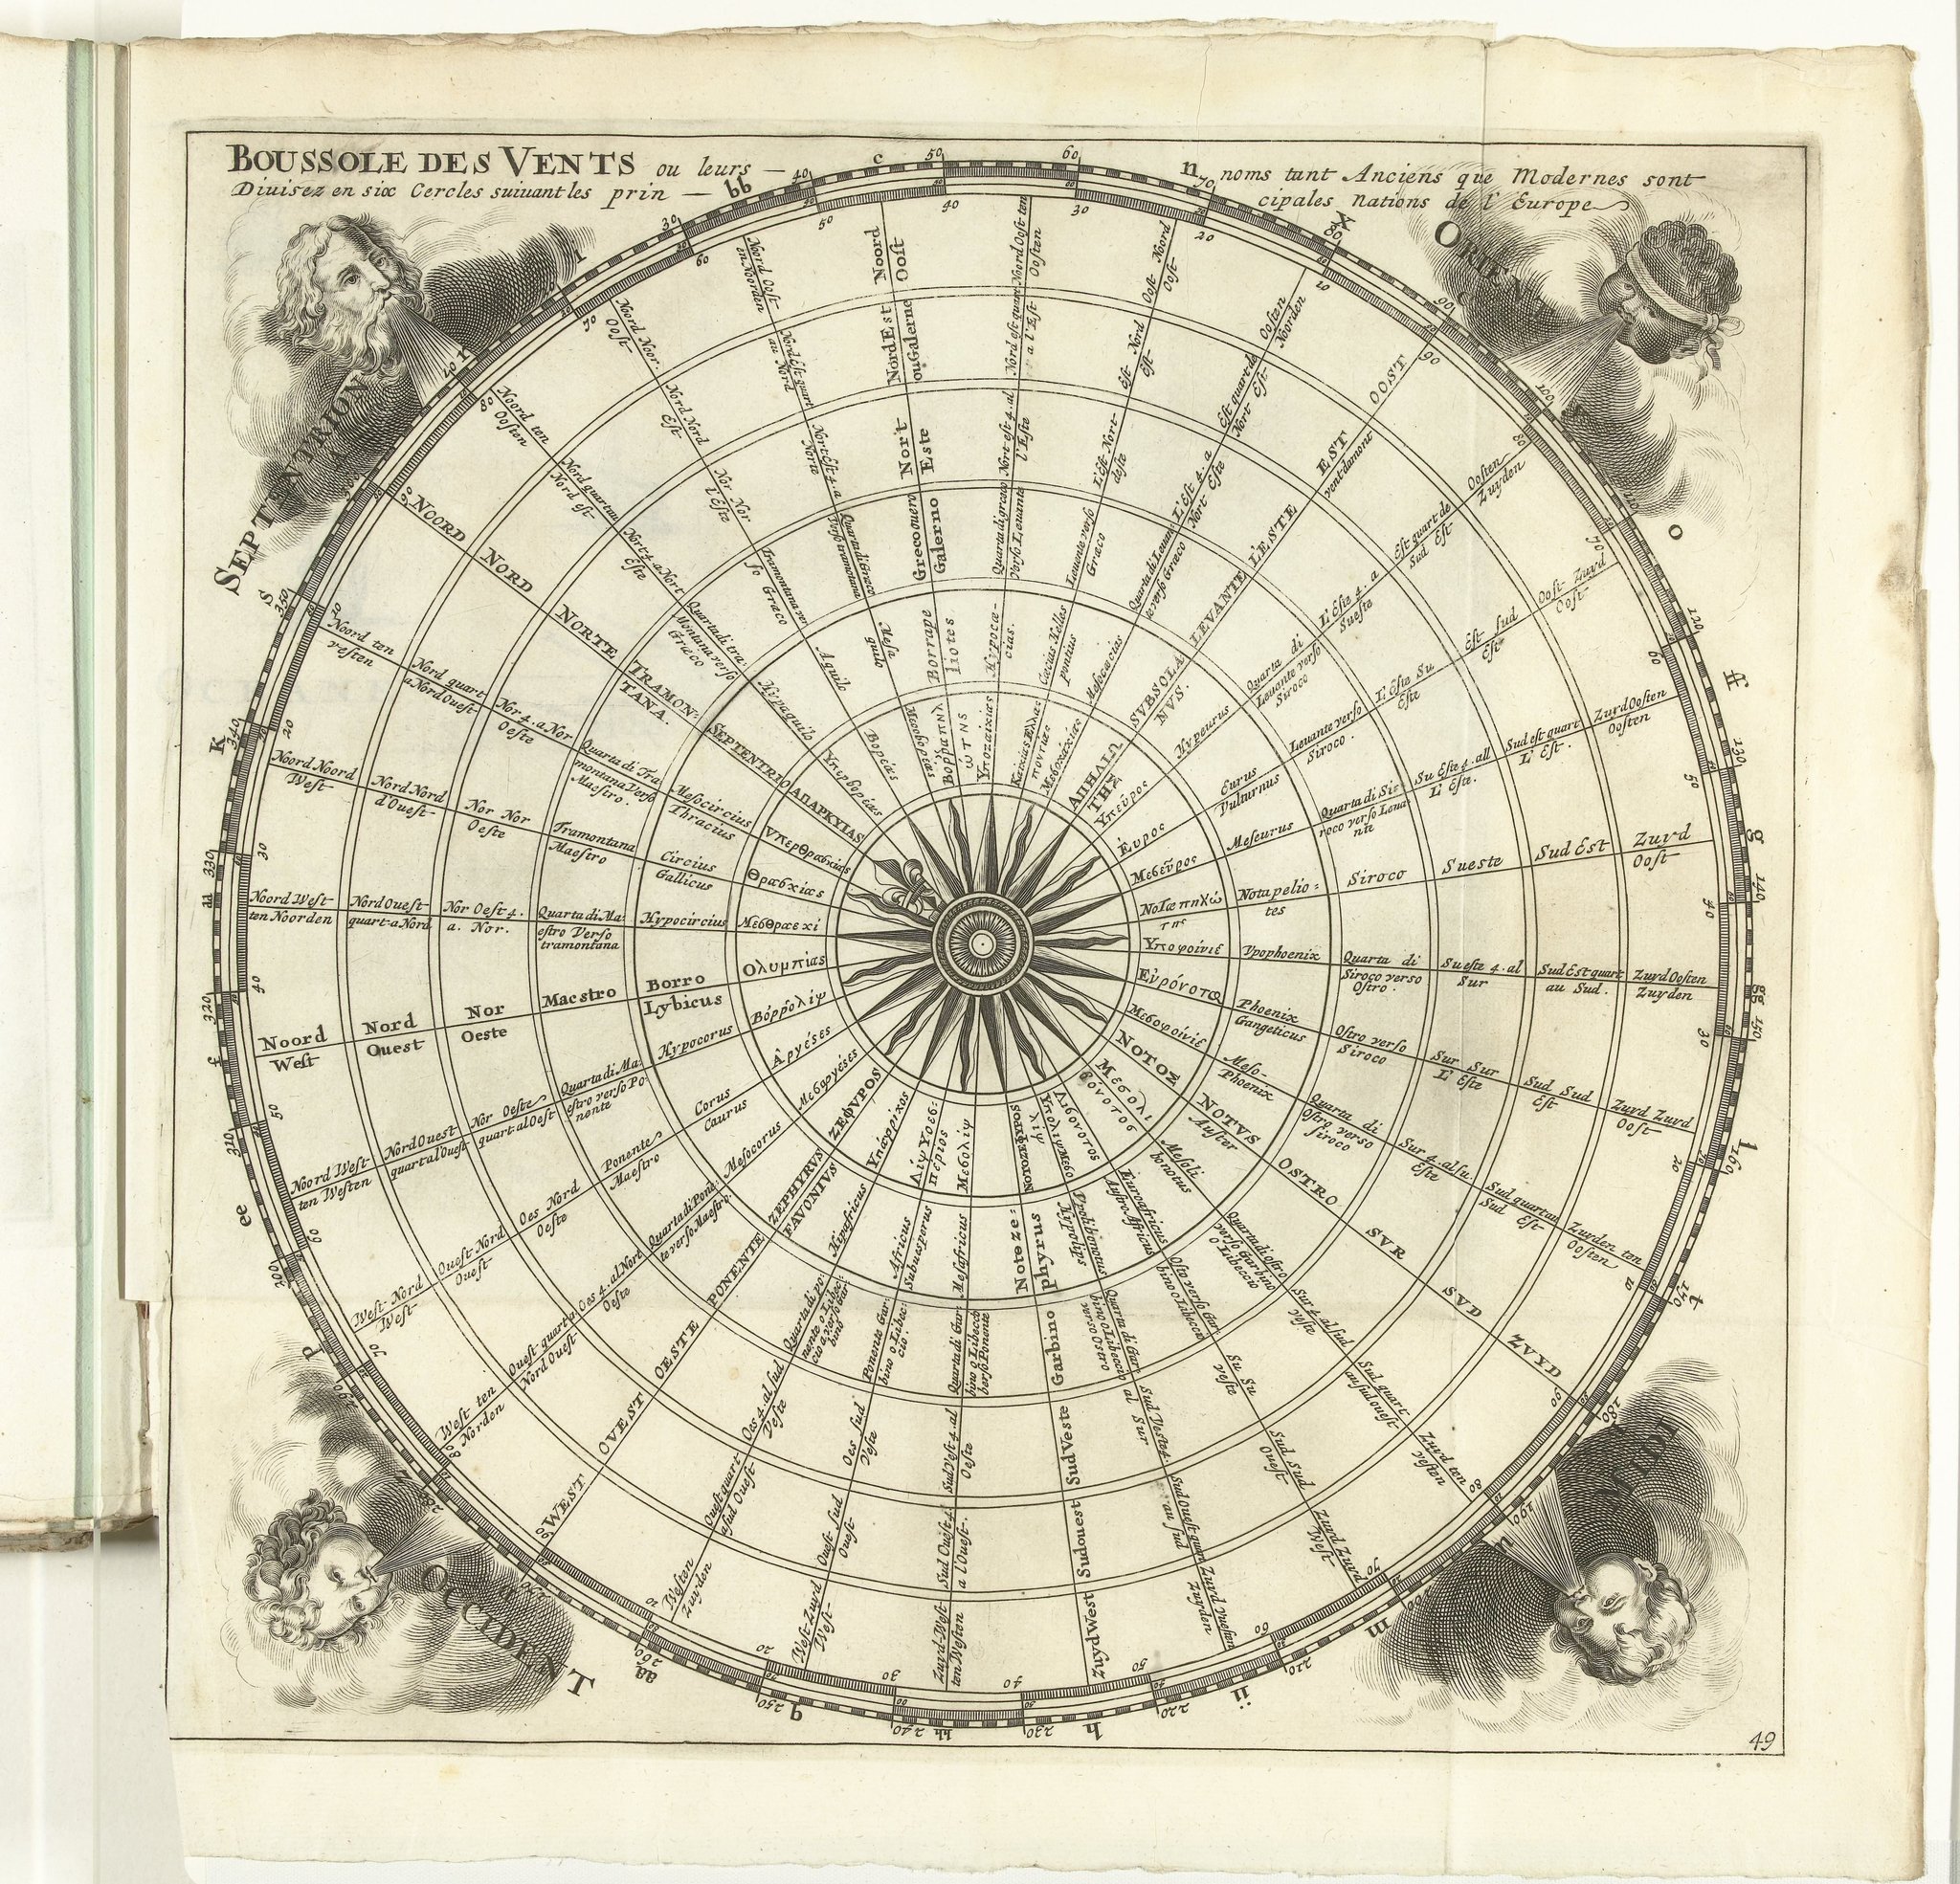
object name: print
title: Boussole des Vents (...)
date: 1702-1703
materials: paper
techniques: engraving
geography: northern netherlands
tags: winds according to several divisions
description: Diagram of tabel met alle windrichtingen en de bijbehorende termen weergegeven in zes talen. In de vier hoeken de blazende windkopppen. In het midden van de windroos een zon met een Franse lelie. Gemerkt rechtsonder: 49. Onderdeel van het eerste van twee delen van het prentwerk: Les costes de France et d'Espagne (oftewel deel 13 van: Les Forces de l'Europe, Asie, Afrique et Amerique), uitgegeven ca. 1702. Het prentwerk bestaat in totaal uit 43 gemerkte platen van de kust van Frankrijk en Spanje, in het kader van de Spaanse Successieoorlog. Deze platen zijn gekopieerd naar anonieme Franse platen oorspronkelijk uitgegeven door Nicolas de Fer te Parijs. Titel in het Frans.